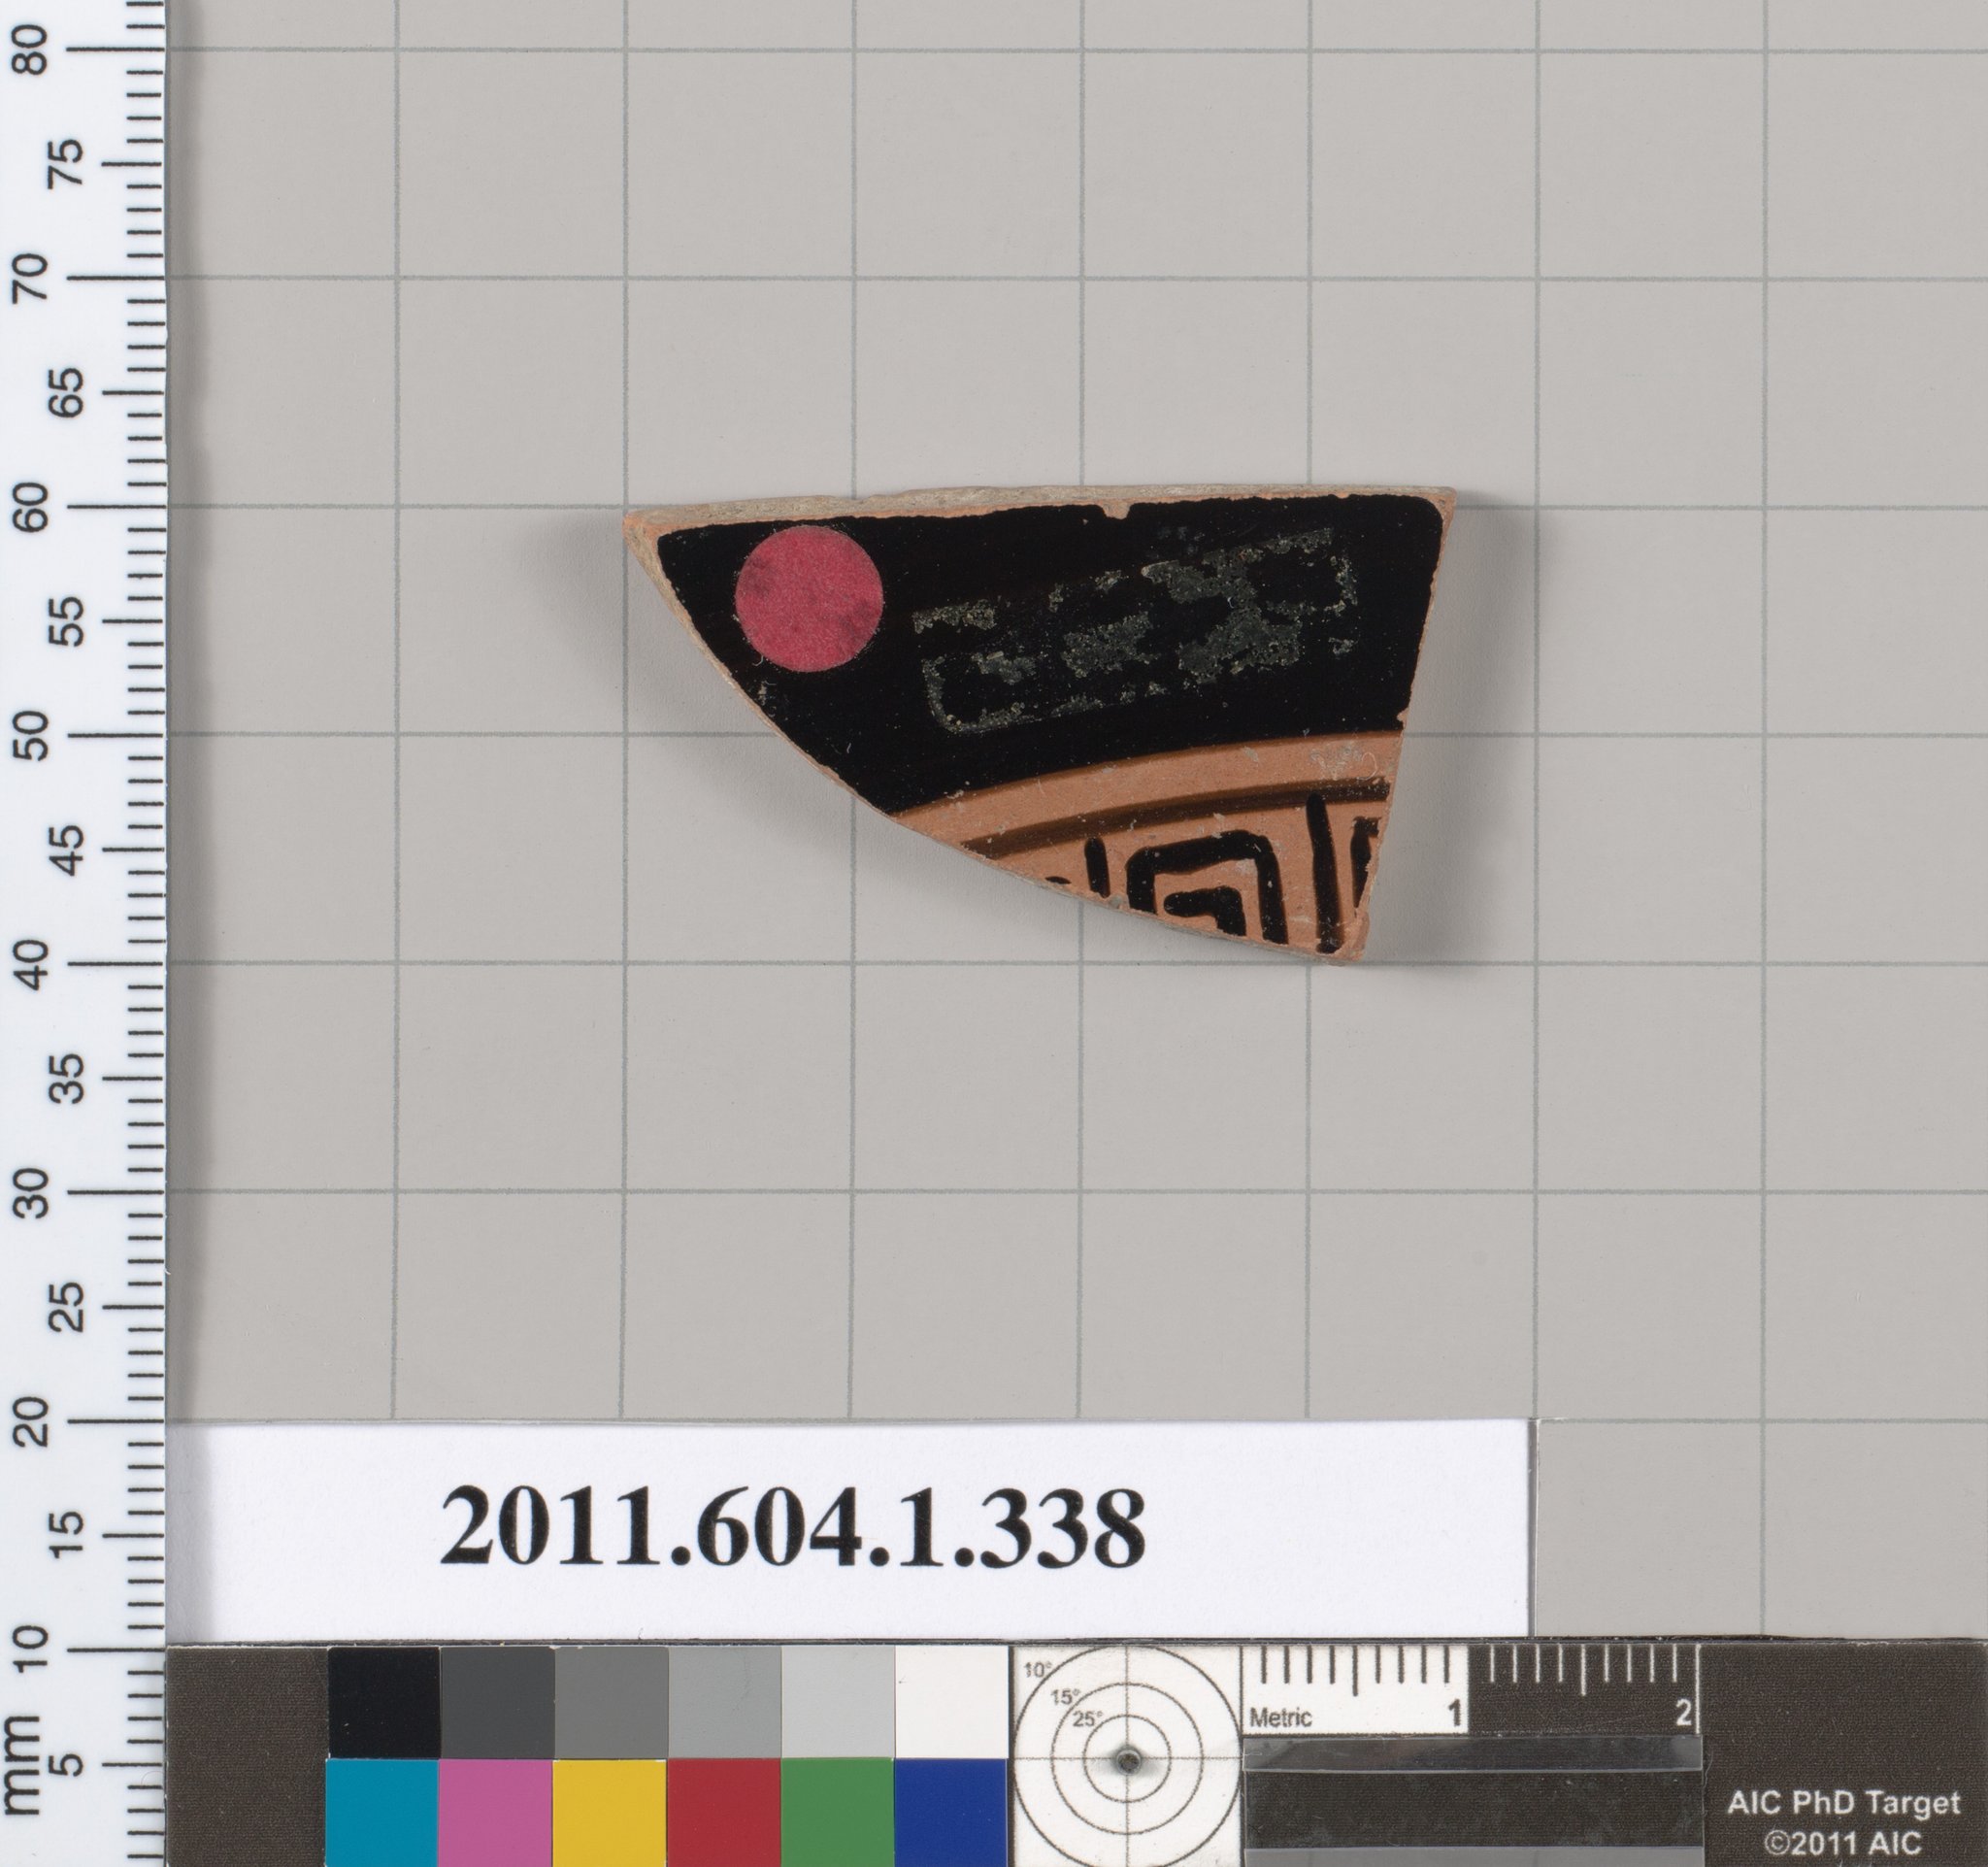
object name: kylix fragment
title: Terracotta fragment of a kylix (drinking cup)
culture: greek, attic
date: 475-451 BCE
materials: terracotta